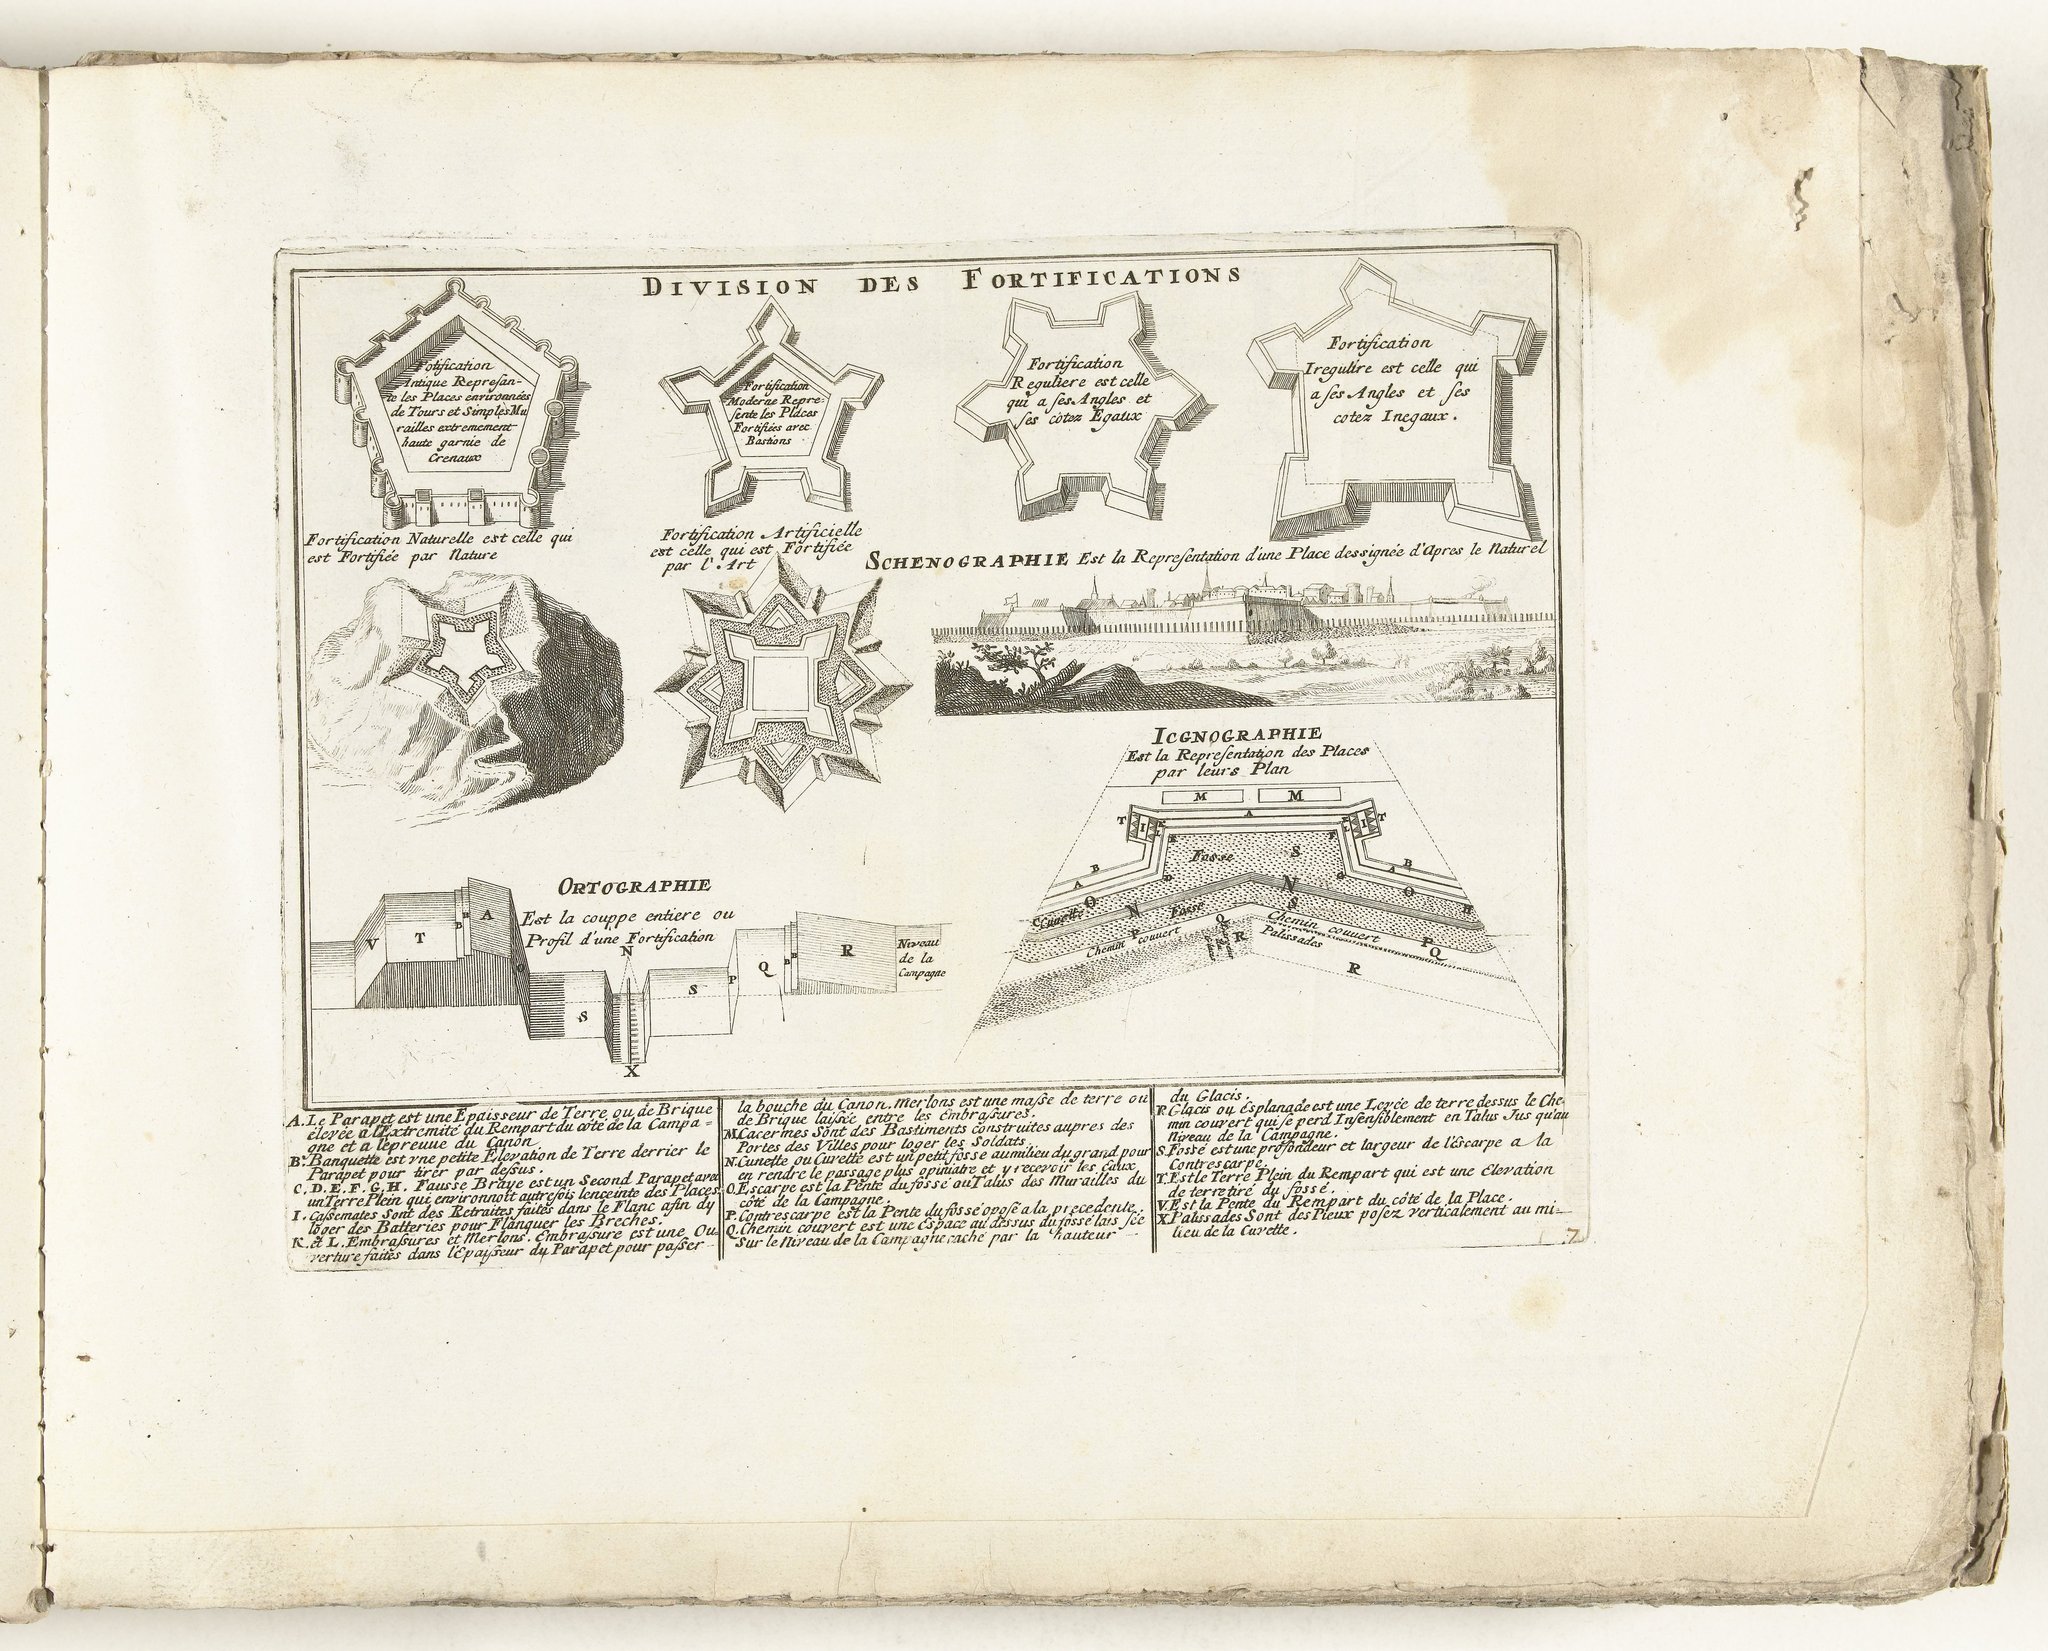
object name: print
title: Diagrammen en doorsneden in de vestingbouw, ca. 1702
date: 1702-1703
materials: paper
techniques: etching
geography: amsterdam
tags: fortifications, military engineering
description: Verschillende diagrammen en doorsneden in de vestingbouw. Plaat nr. 7 in het prentwerk bestaande in totaal uit 276 genummerde platen van vermaarde sterke steden en vestingen in het kader van de Spaanse Successieoorlog. Voor het merendeel zijn deze platen gekopieerd naar de anonieme Franse platen: in Les forces de l'Europe en in: Le theatre de la guerre, dans les Pays-Bas, beide oorspronkelijk uitgegeven door Nicolas de Fer te Parijs (1693-1697) in het kader van de Negenjarige Oorlog. Titel en opschriften in het Frans.